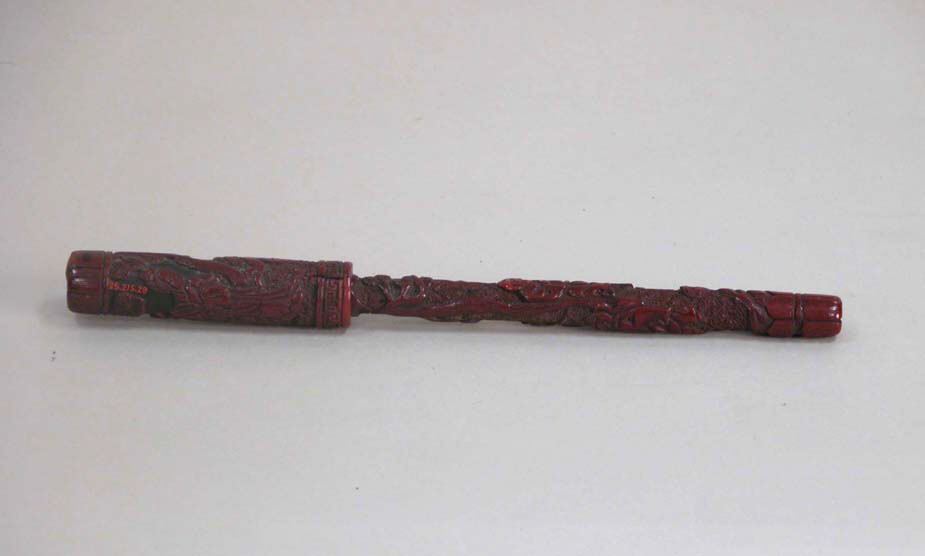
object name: writing brush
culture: chinese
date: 1368-1644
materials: lacquer, wood